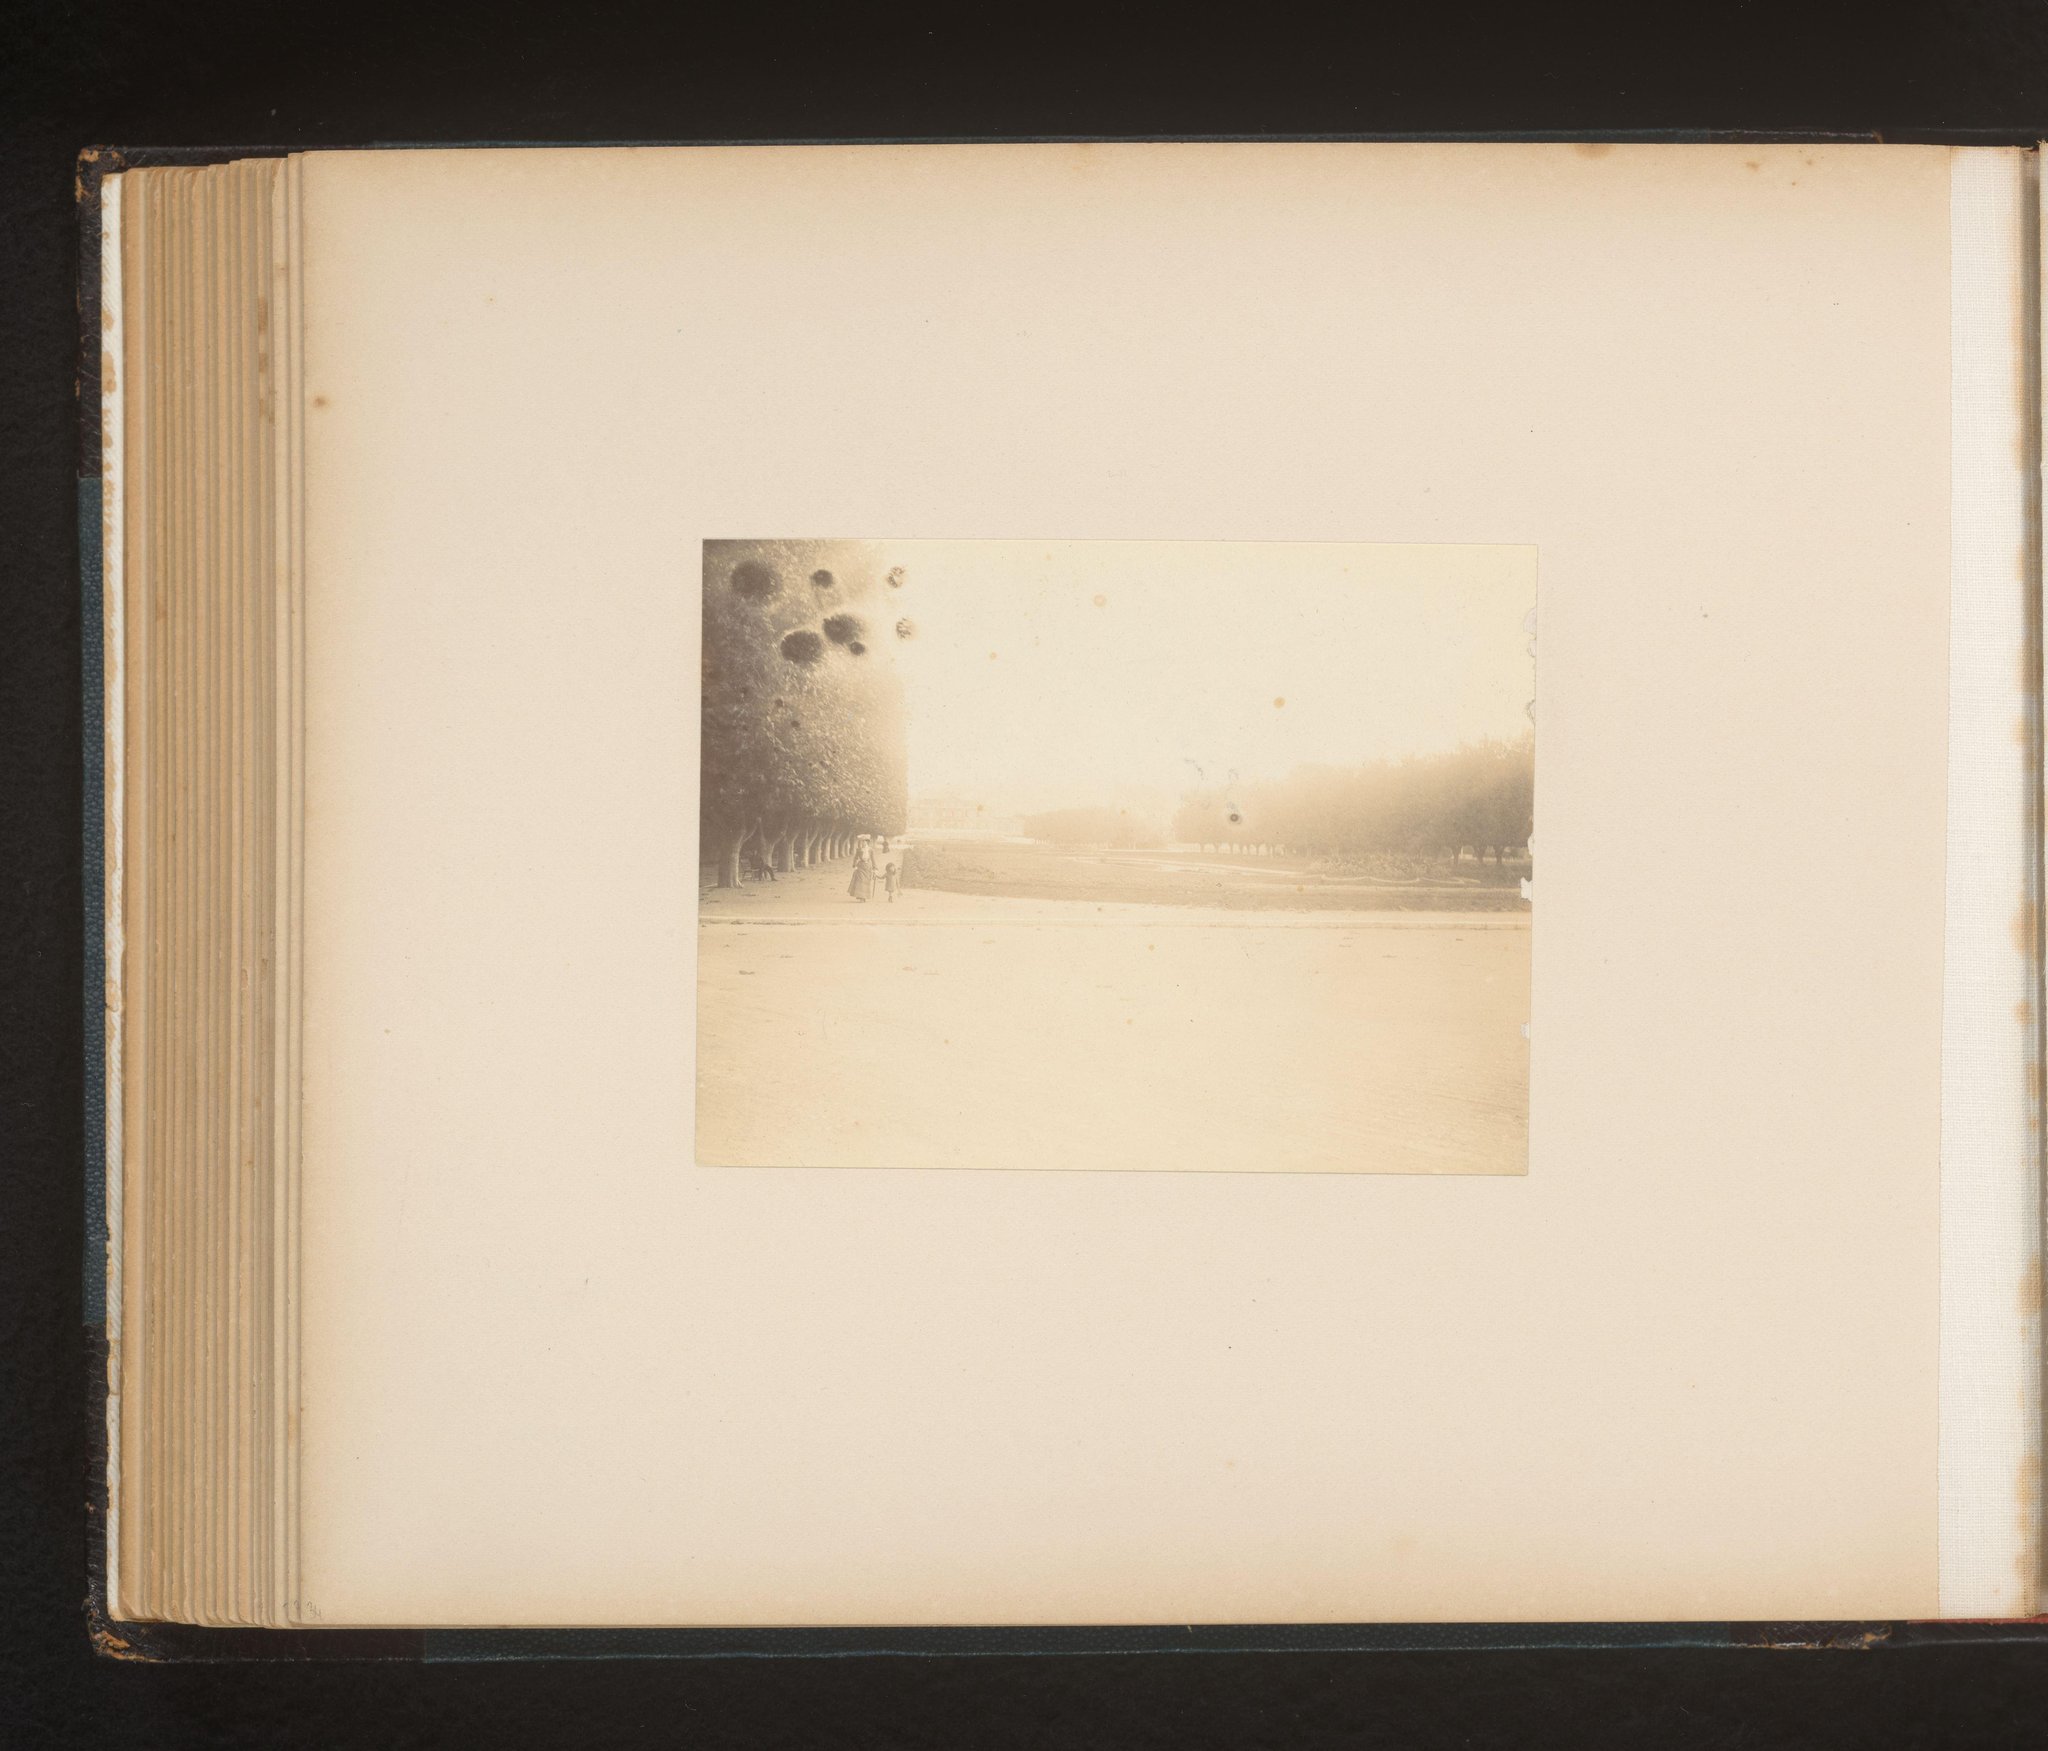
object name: album leaf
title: Landgoed of park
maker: Anonymous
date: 1880-1920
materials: cardboard, photographic support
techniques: gelatin silver print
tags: historical persons, public gardens, park, france